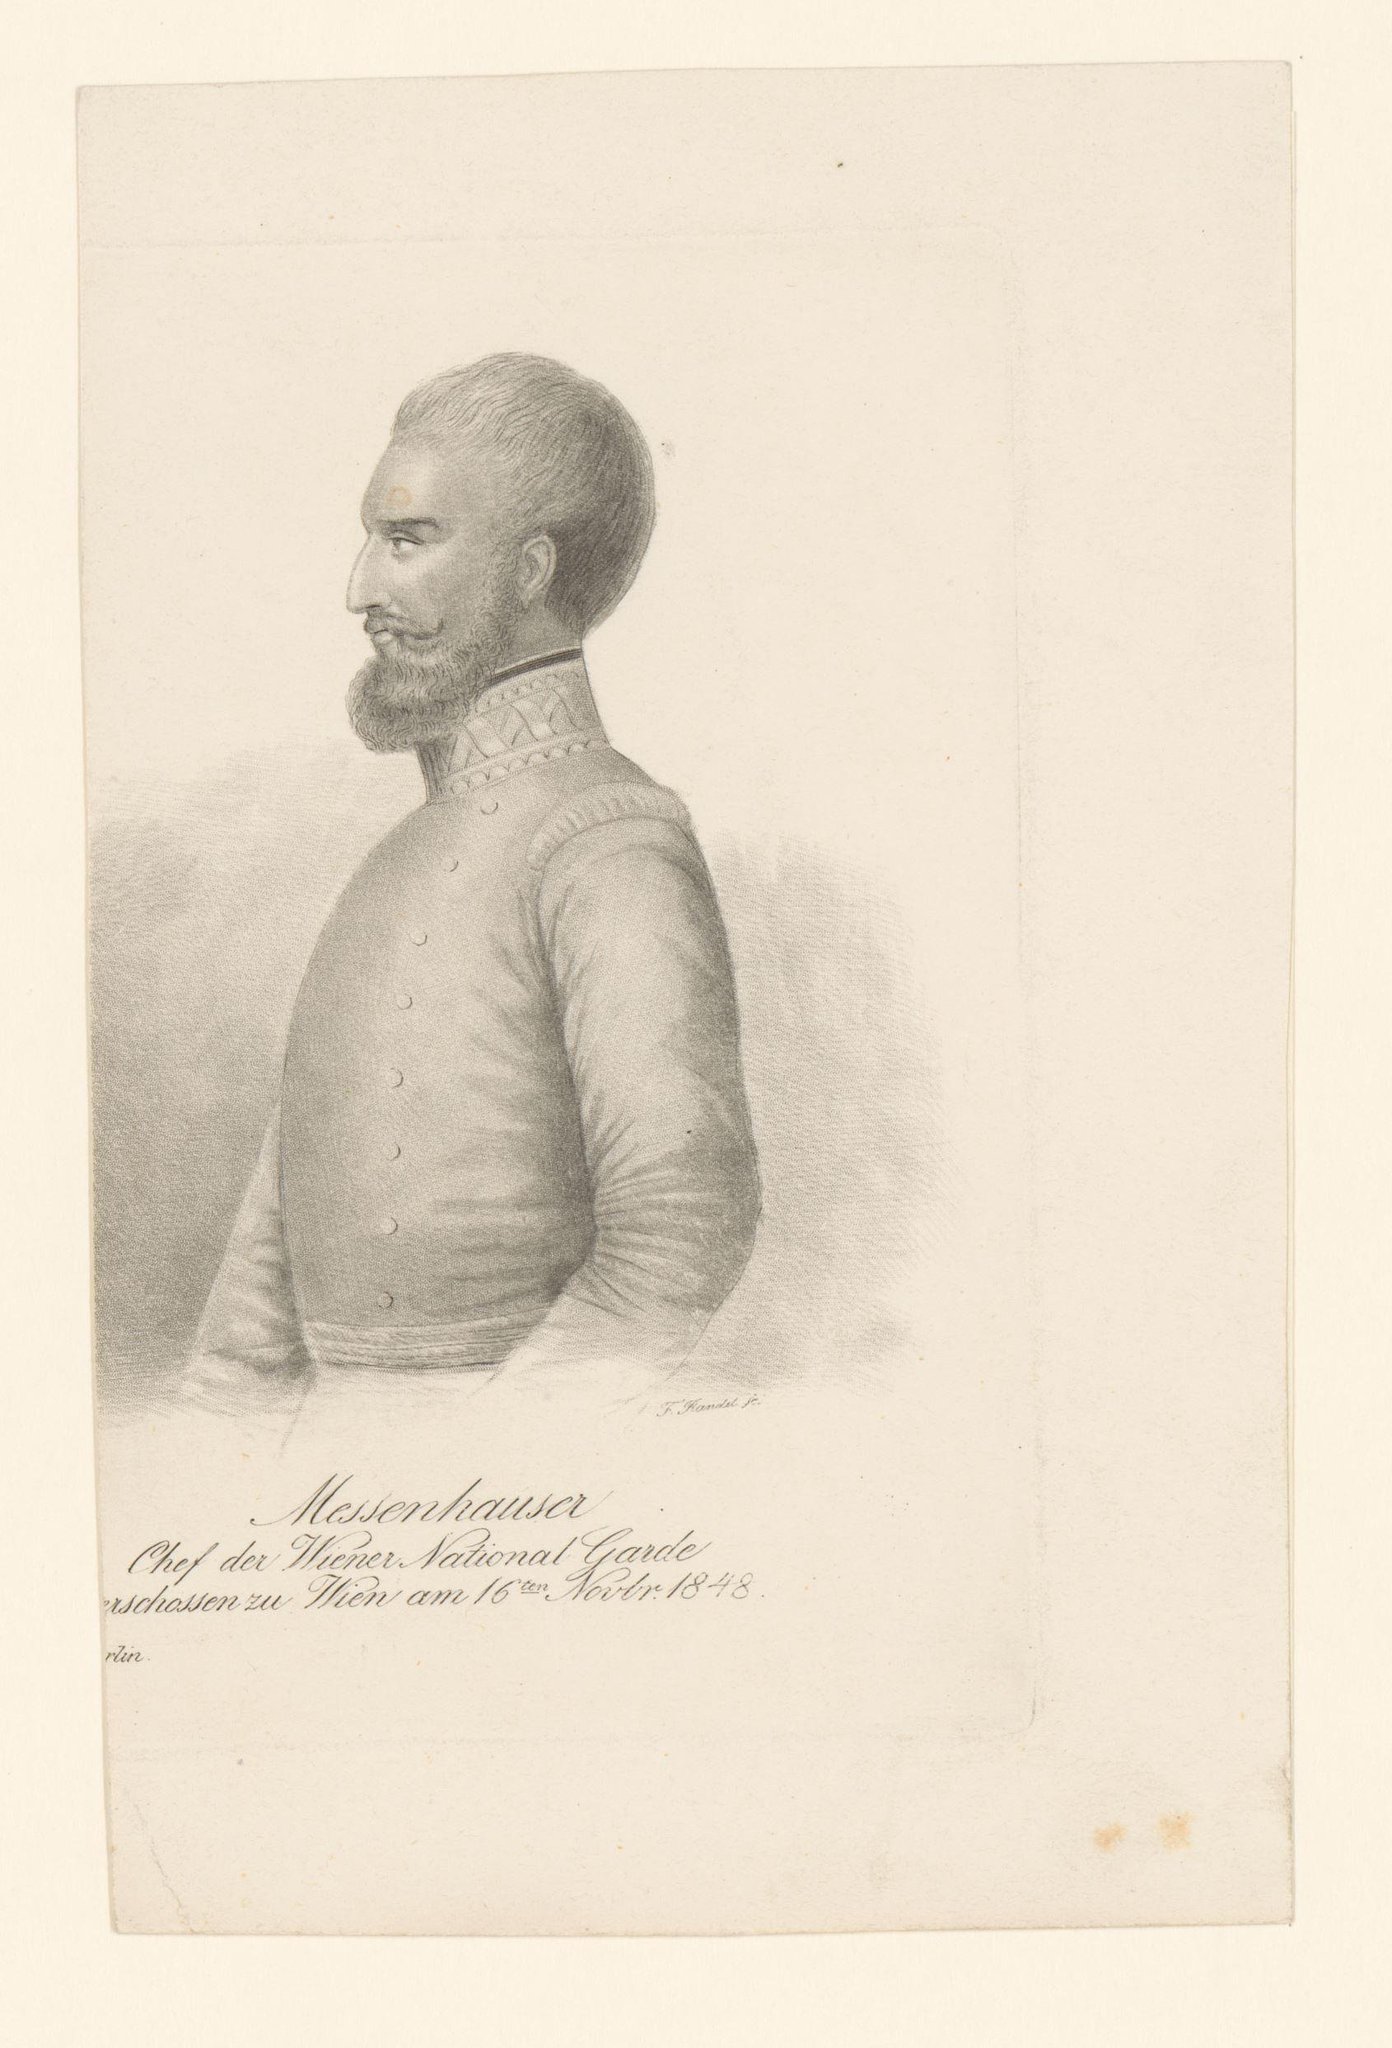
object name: print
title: Portret van Wenzel Messenhauser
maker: f. randel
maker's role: print maker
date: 1848-1899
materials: paper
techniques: engraving, roulette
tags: vienna, historical persons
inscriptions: collector's mark: Lugt 2228